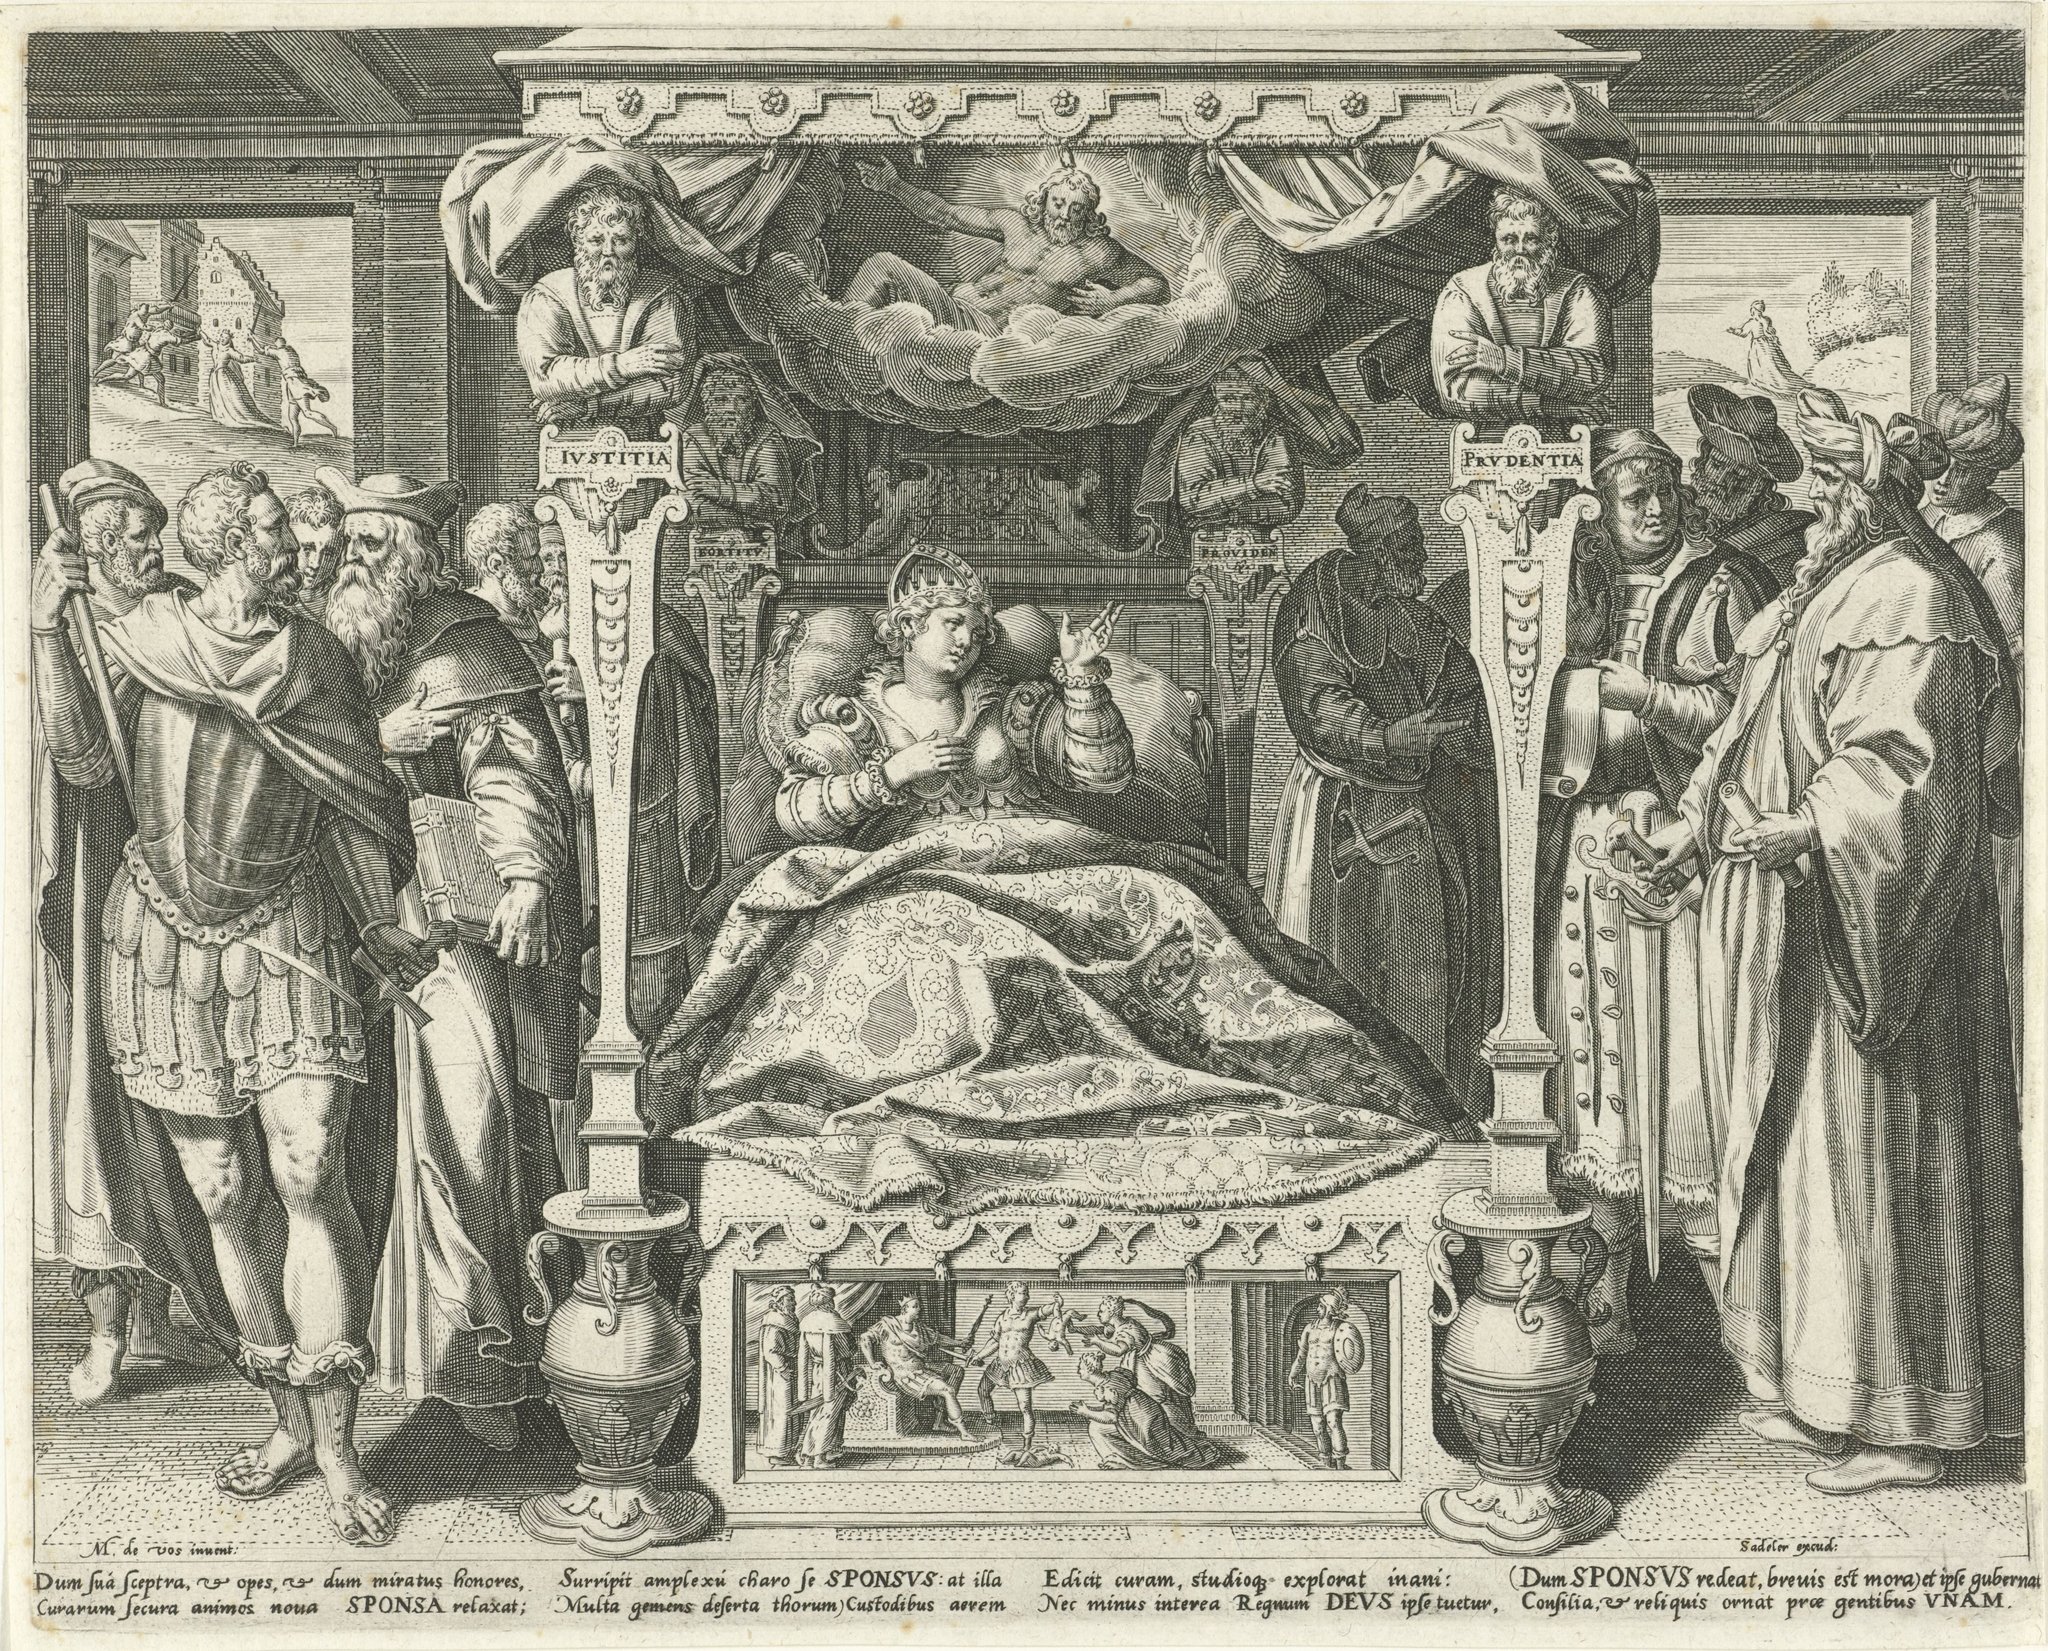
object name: print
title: Hooglied van Salomo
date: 1590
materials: paper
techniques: engraving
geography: antwerp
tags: fortitude, 'fortitudo' ~ one of the four cardinal virtues, 'ecclesia' as bride of christ (the lamb), 'ecclesia sponsa dei', 'sponsus-sponsa', song of solomon, song of songs (with book chapter:verse) (+ christ bearded), the judgement of solomon (1 kings 3:16-28), justice, 'justitia'; 'giustitia divina' (ripa) ~ one of the four cardinal virtues, prudence, 'prudentia'; 'prudenza' (ripa) ~ one of the four cardinal virtues, caryatids ~ architecture, bed with tester, forethought, deliberation; 'previdenza', 'providenza' (ripa), groups of persons from the old testament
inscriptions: collector's mark: Lugt 240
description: De bruid van Christus (de kerk) in een bed met een baldakijn. Het baldakijn wordt gedragen door de kardinale deugden. Op het voeteneind een voorstelling van het oordeel van Salomon. Boven het hoofd van de bruid Christus in een wolk. Rond het bed figuren uit het Oude Testament. Op de achtergrond door een deuropening is de bruid van Christus te zien die in de stad op zoek is naar haar geliefde. De prent heeft een Latijns onderschrift over het hooglied van Salomo en is de derde prent van een zesdelige serie.